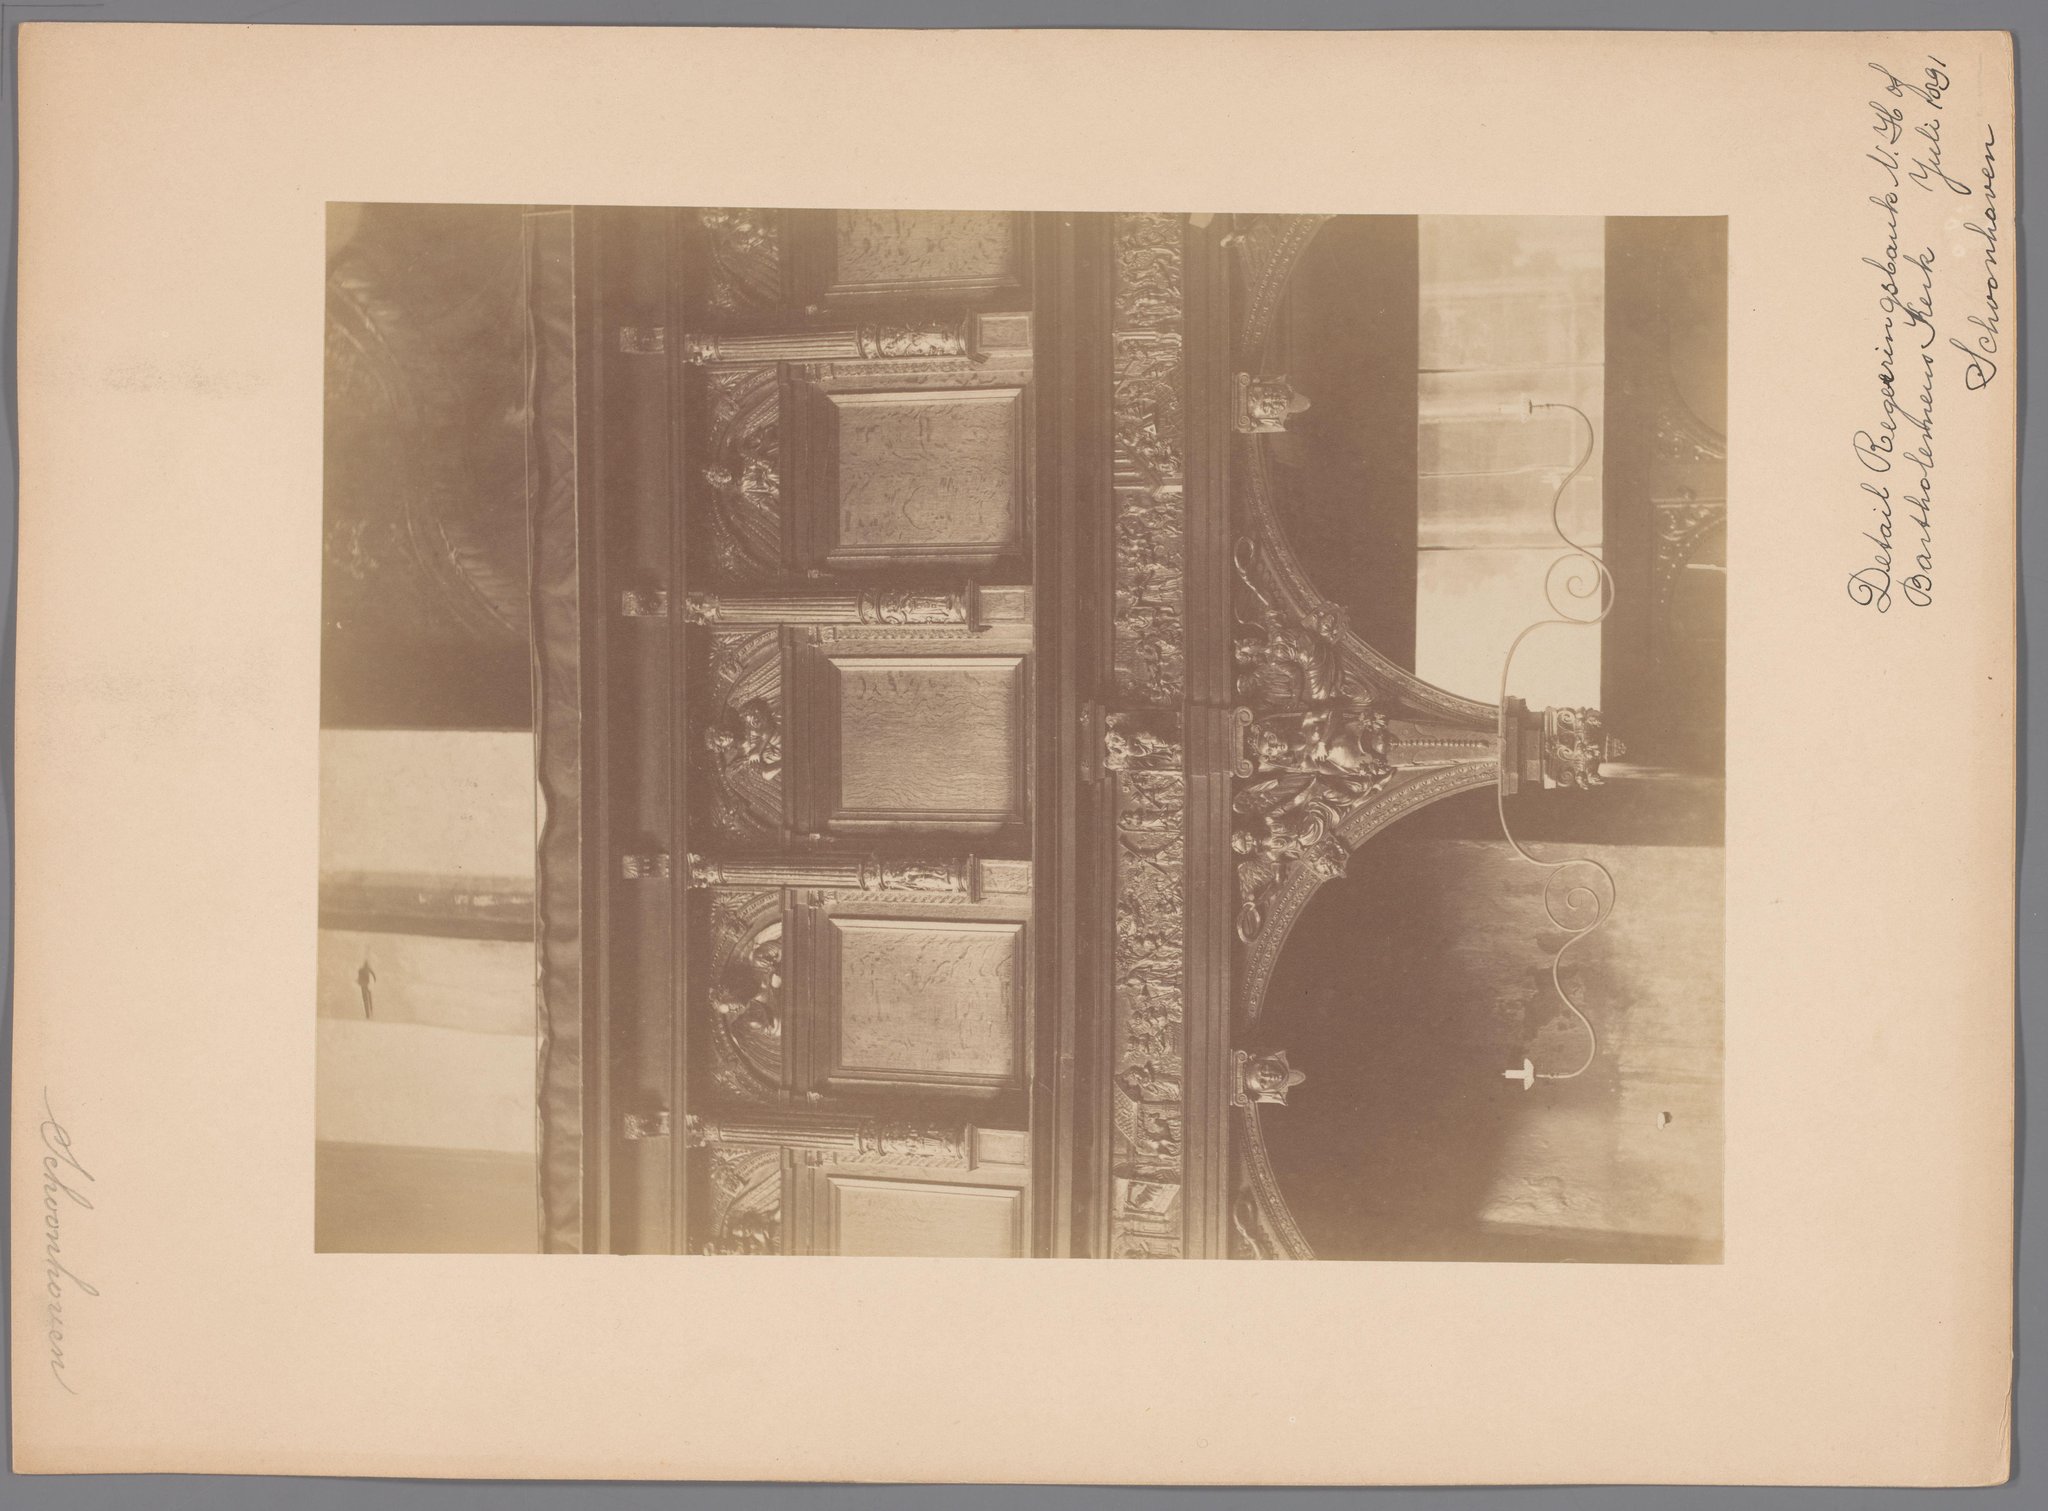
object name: photograph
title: Detail van de Regeringsbank in de Grote of Bartholomeüskerk te Schoonhoven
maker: anoniem (monumentenzorg)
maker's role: fotograaf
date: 1891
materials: cardboard, photographic support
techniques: albumen print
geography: grote of bartholomeüskerk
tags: parts of church interior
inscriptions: annotation: ‘Detail Regeringsbank N.H. of Bartholomeus Kerk/ Juli 1891/ Schoonhoven’, annotation: ‘Schoonhoven/ Detail Regerings bank’